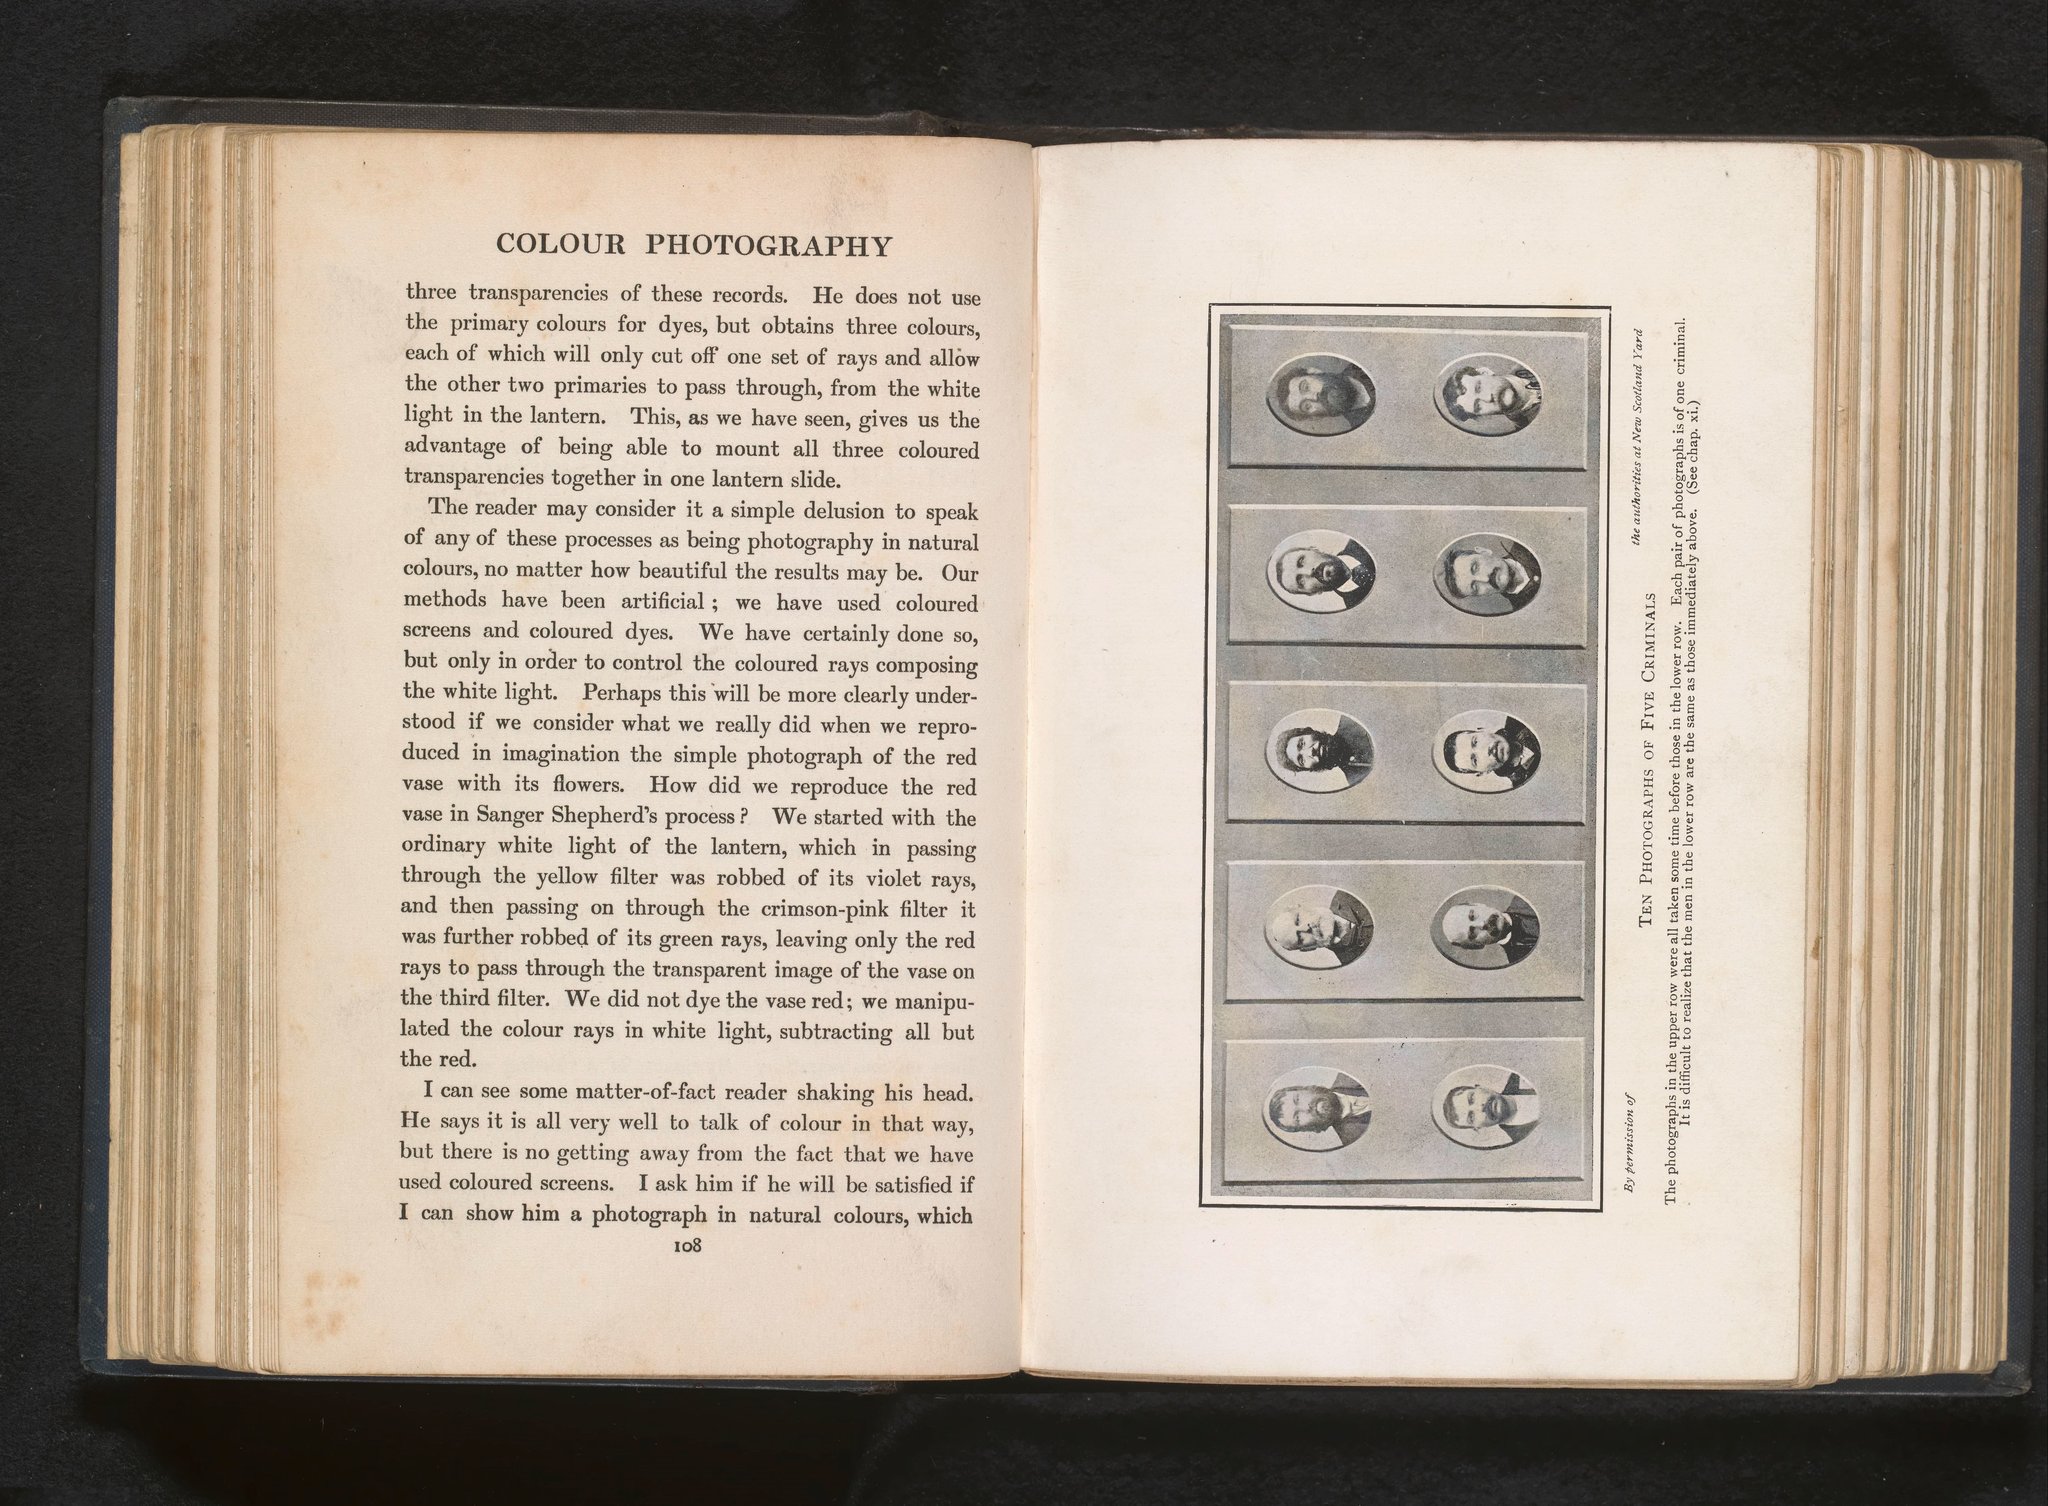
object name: photomechanical print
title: Ten photographs of five criminals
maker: Anonymous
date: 1898-1908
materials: paper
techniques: autotype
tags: criminals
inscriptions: inscription: ‘By permission of the authorities at New Scotland Yard. The photographs in the upper row were all taken some time before those in th lower row. Each pair of photographs is of one criminal. It is difficult te realize that the men in the lower row are the same as those immediately above. (See chap. xi.)’